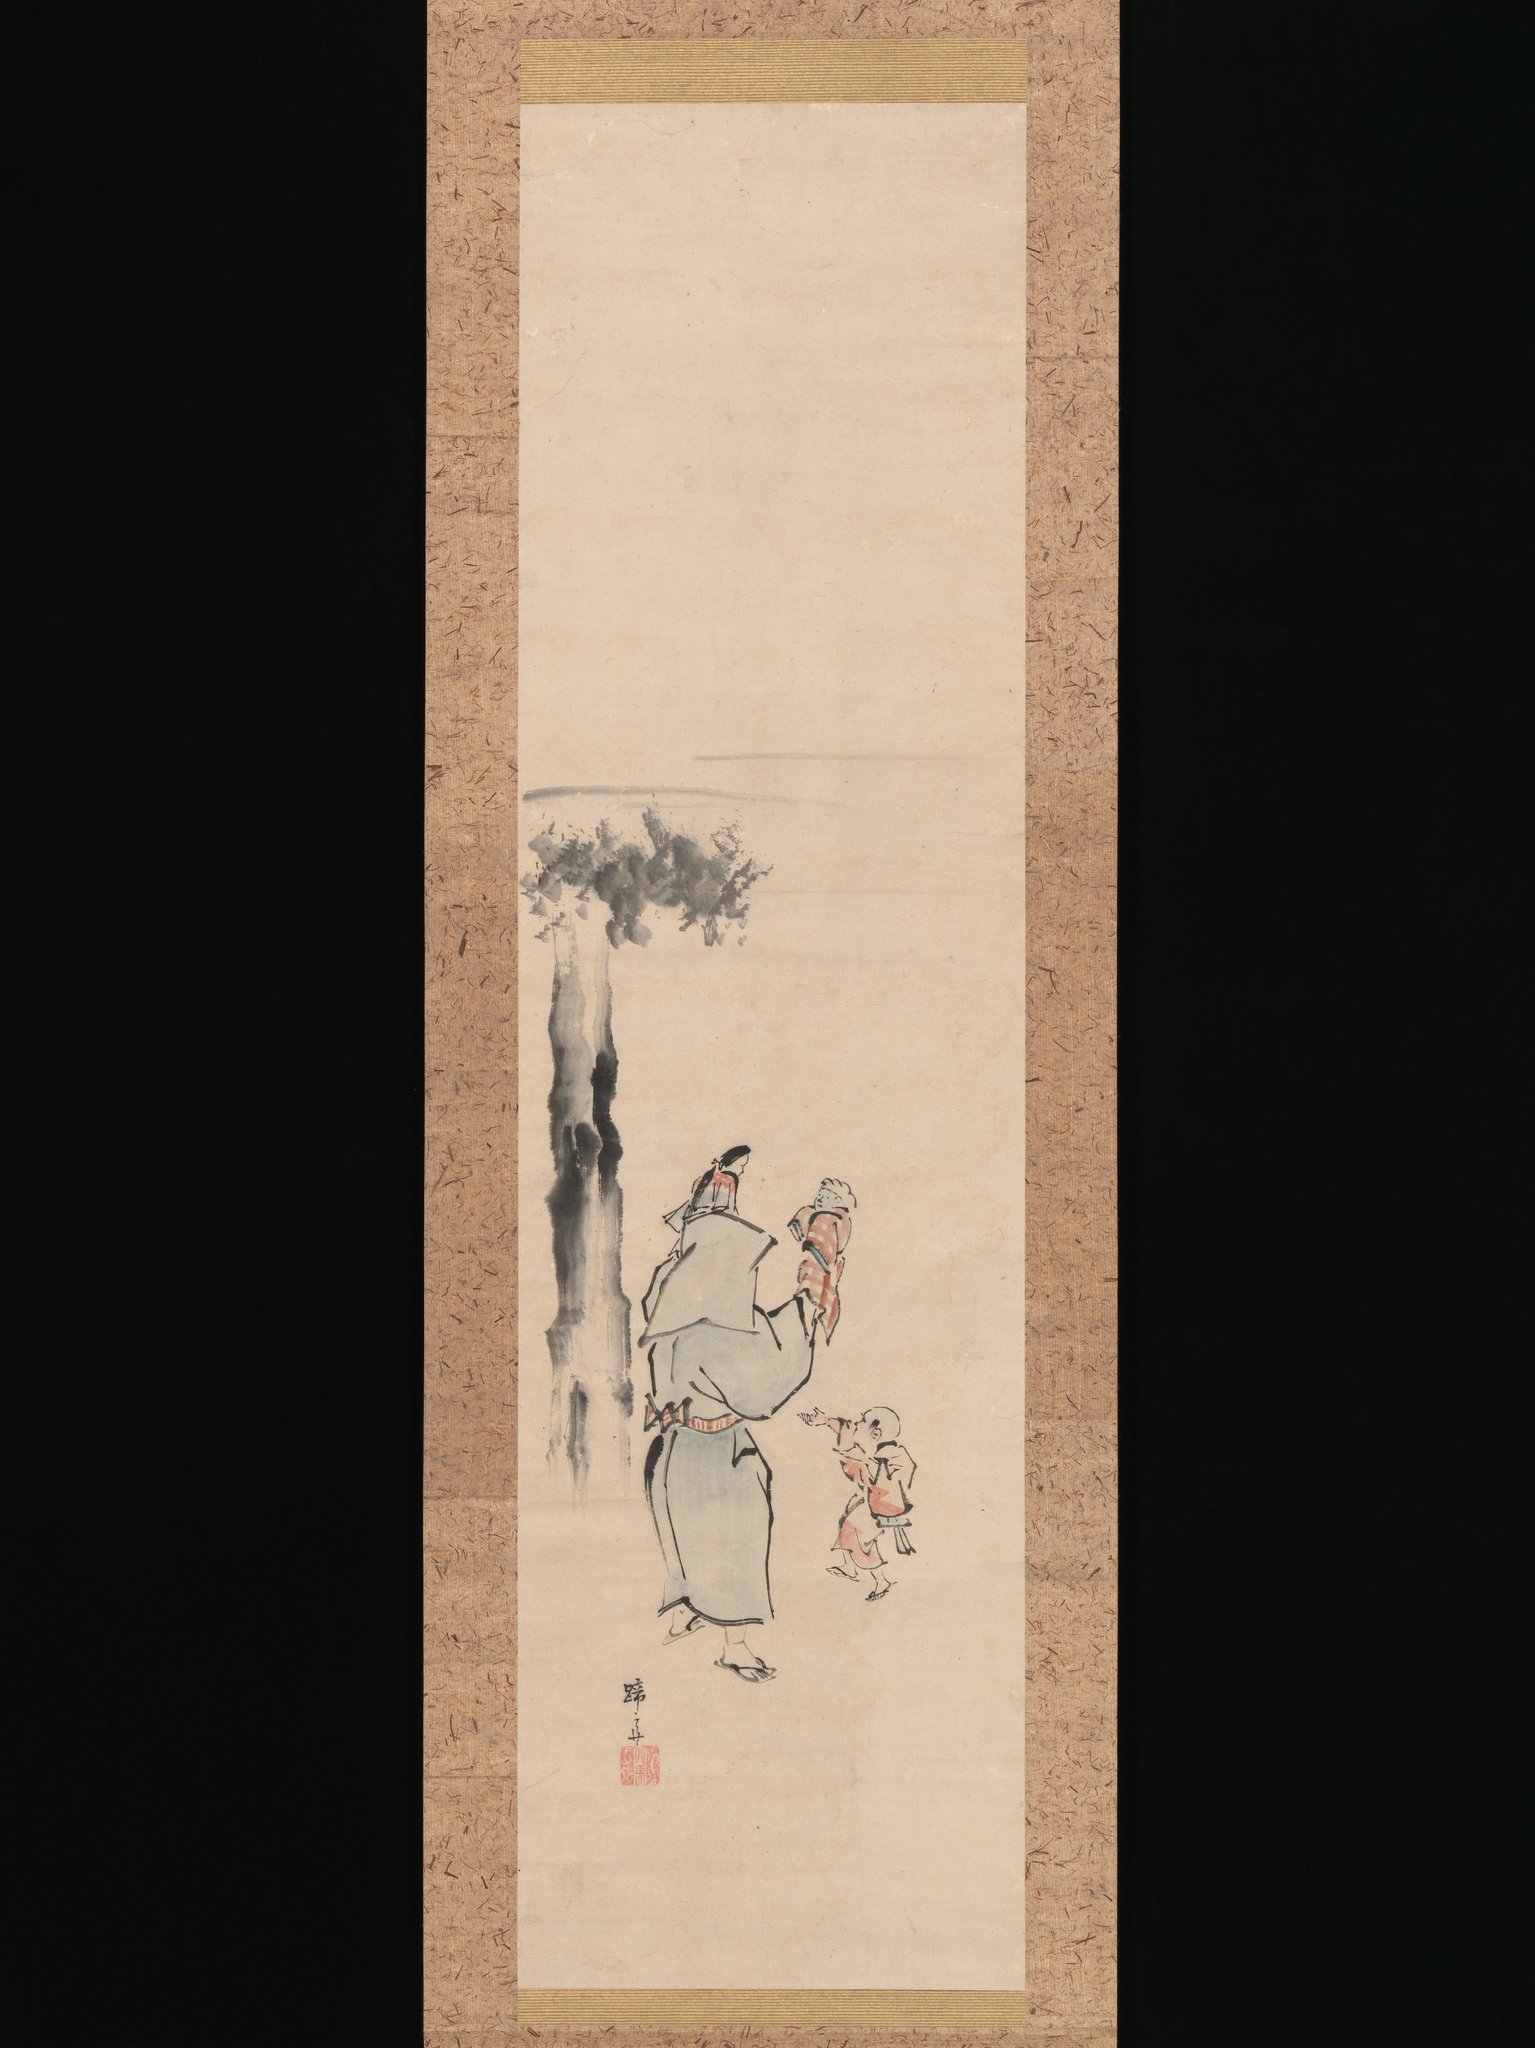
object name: hanging scroll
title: Puppeteer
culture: japanese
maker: teisai hokuba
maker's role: artist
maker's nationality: japanese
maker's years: 1771-1844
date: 1801-1900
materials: ink, paper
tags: children,puppets